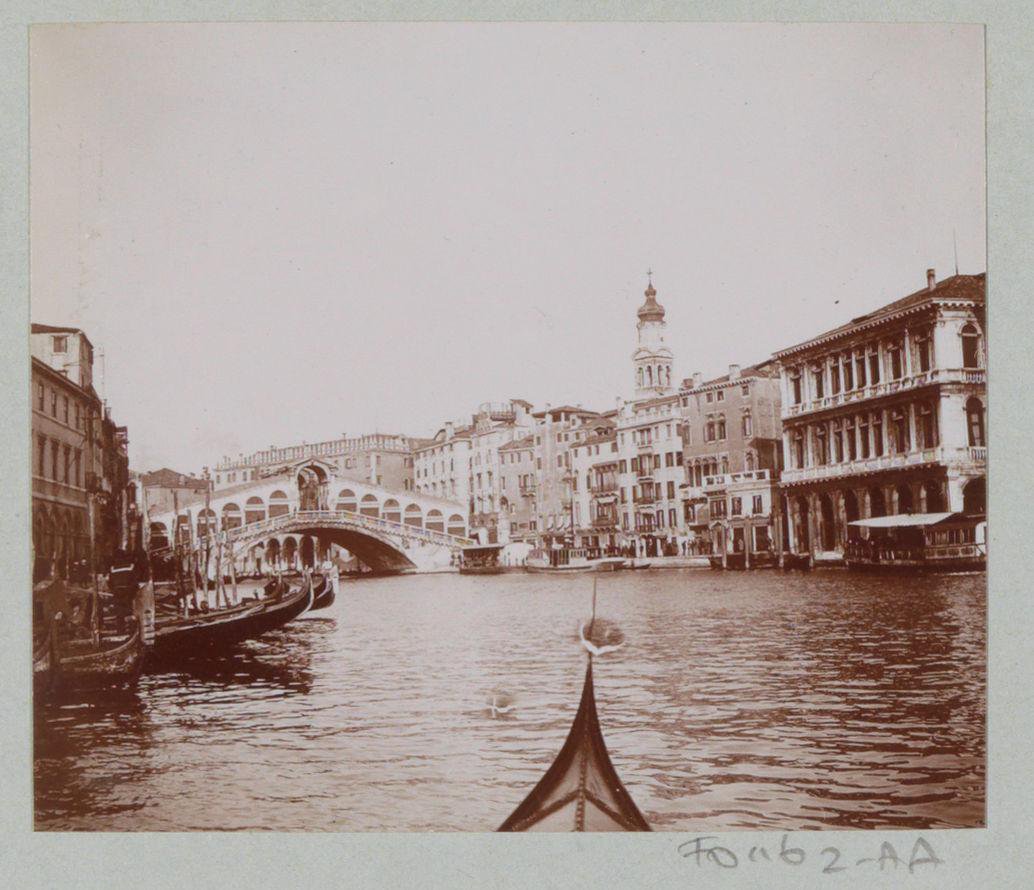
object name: photograph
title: Canal Grande met de Rialtobrug in Venetië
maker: Anonymous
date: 1905-1910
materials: paper, photographic support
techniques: gelatin silver print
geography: venice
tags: canals, waters (in city), bridge in city across river, canal, etc., venice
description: Onderdeel van Fotoalbum van een Franse amateurfotograaf met bezienswaardigheden in Frankrijk, Zwitserland en Italië.